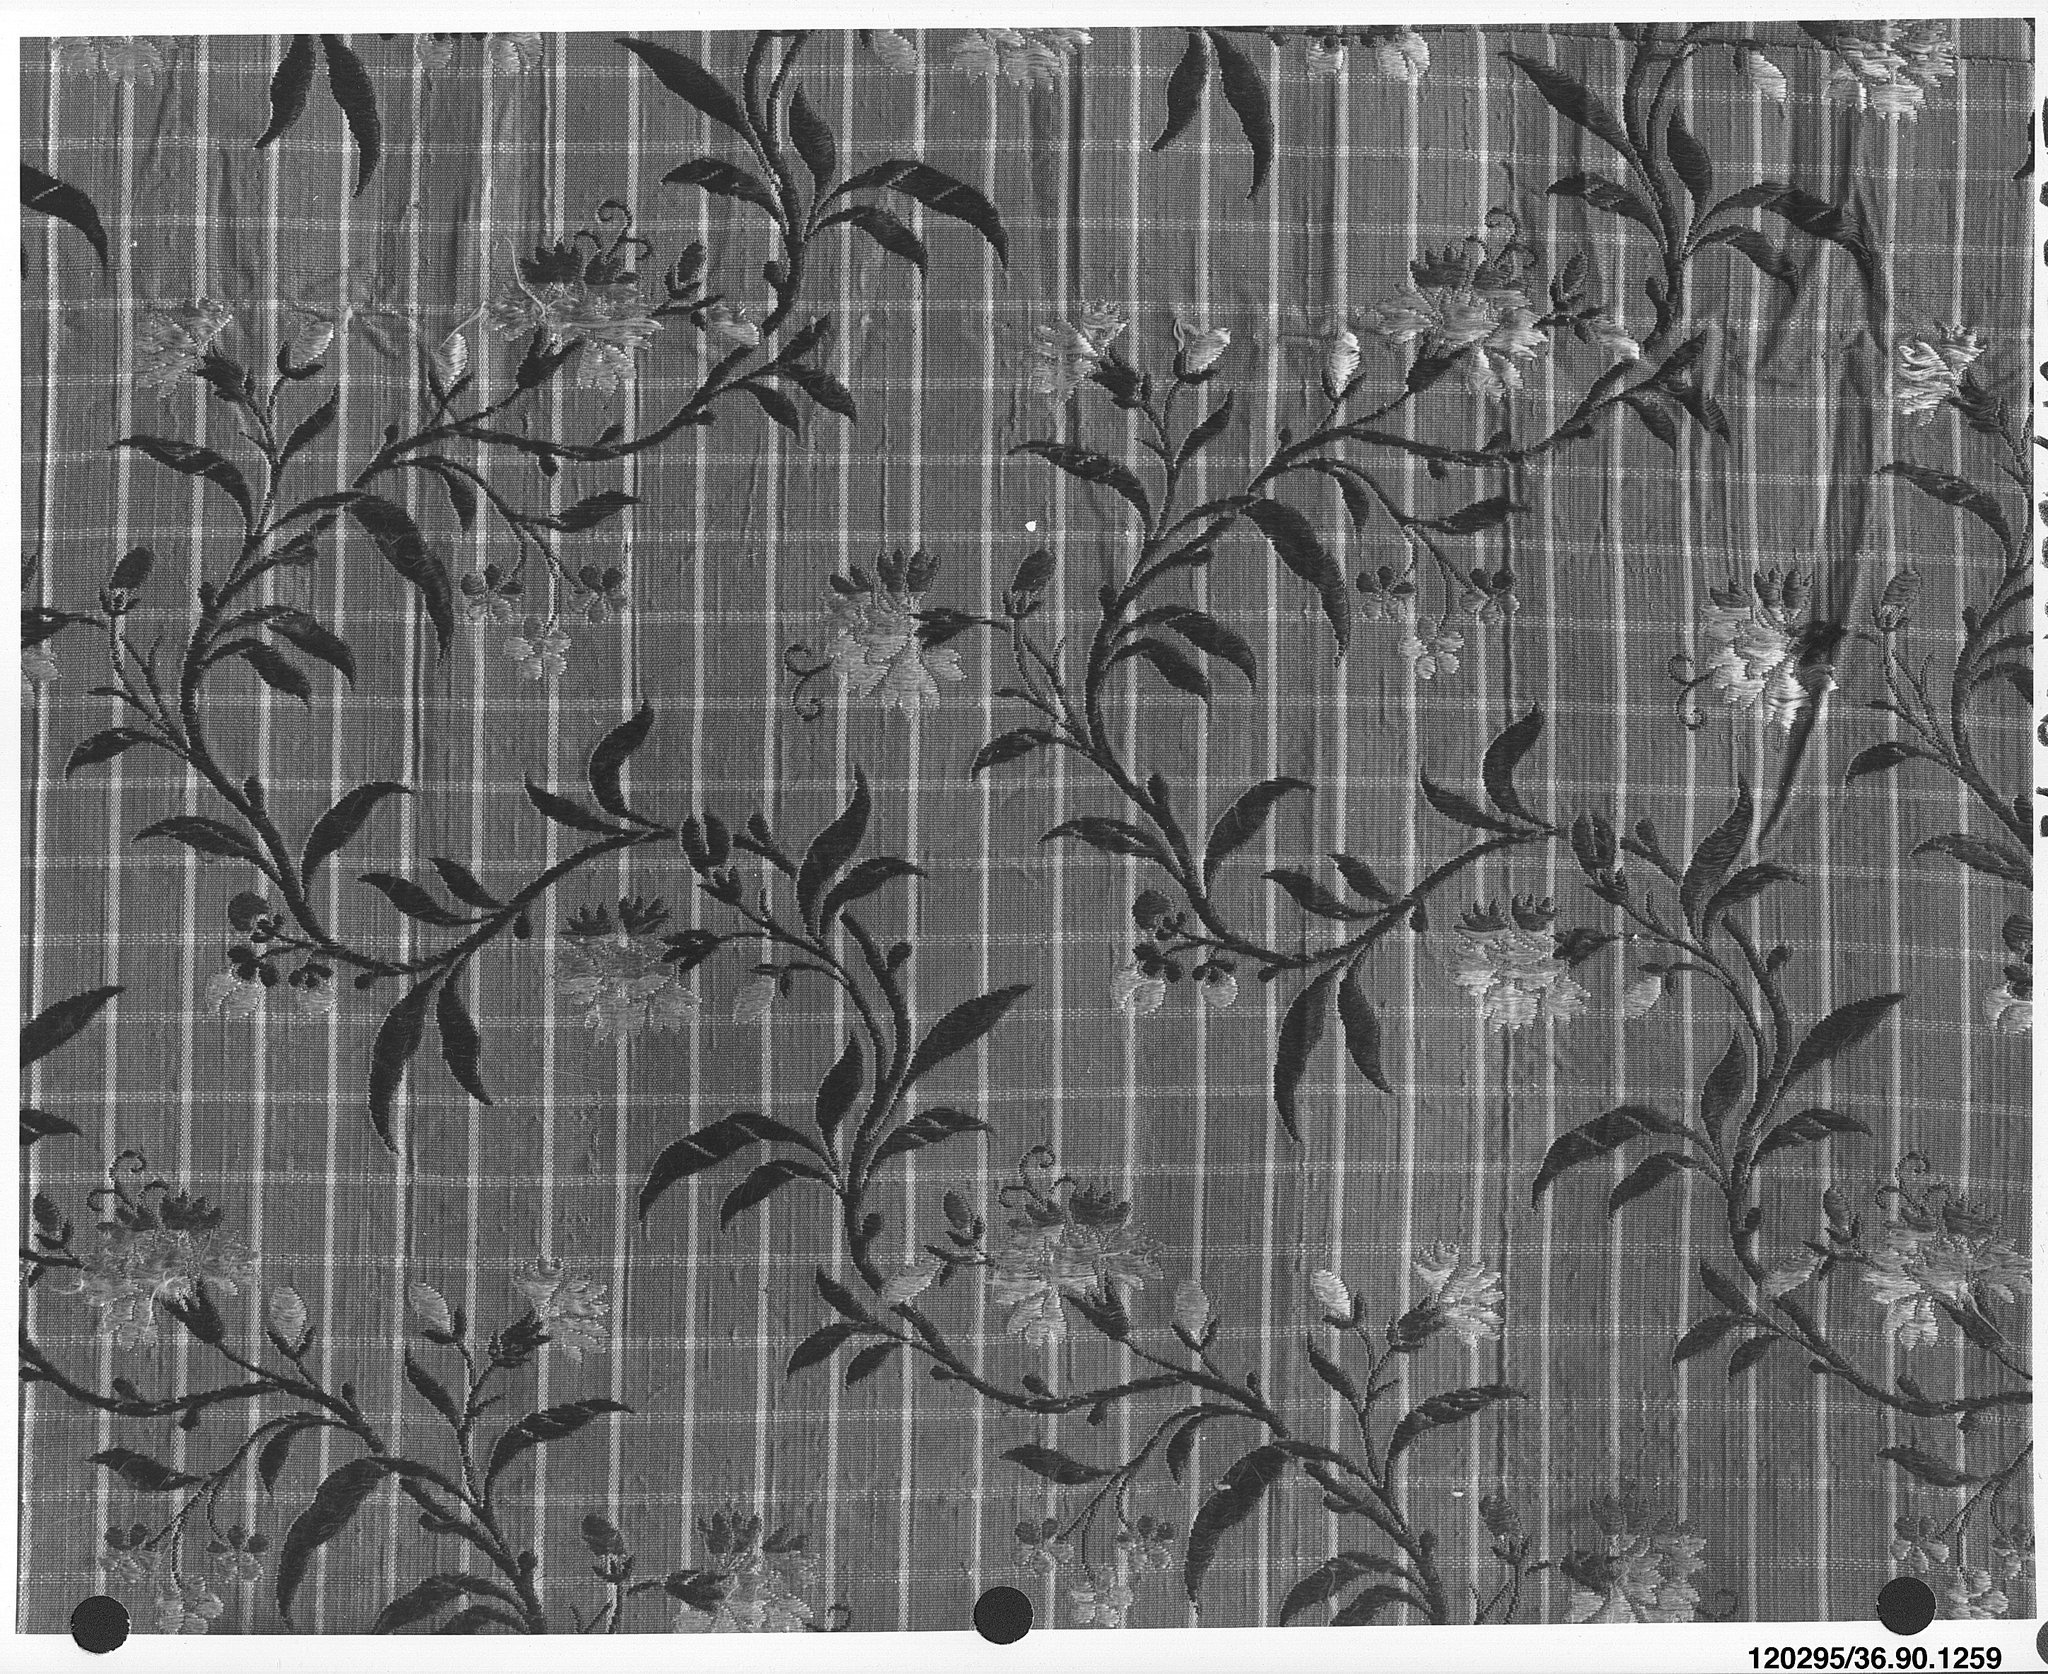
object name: piece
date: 1760-1770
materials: silk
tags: flowers,leaves